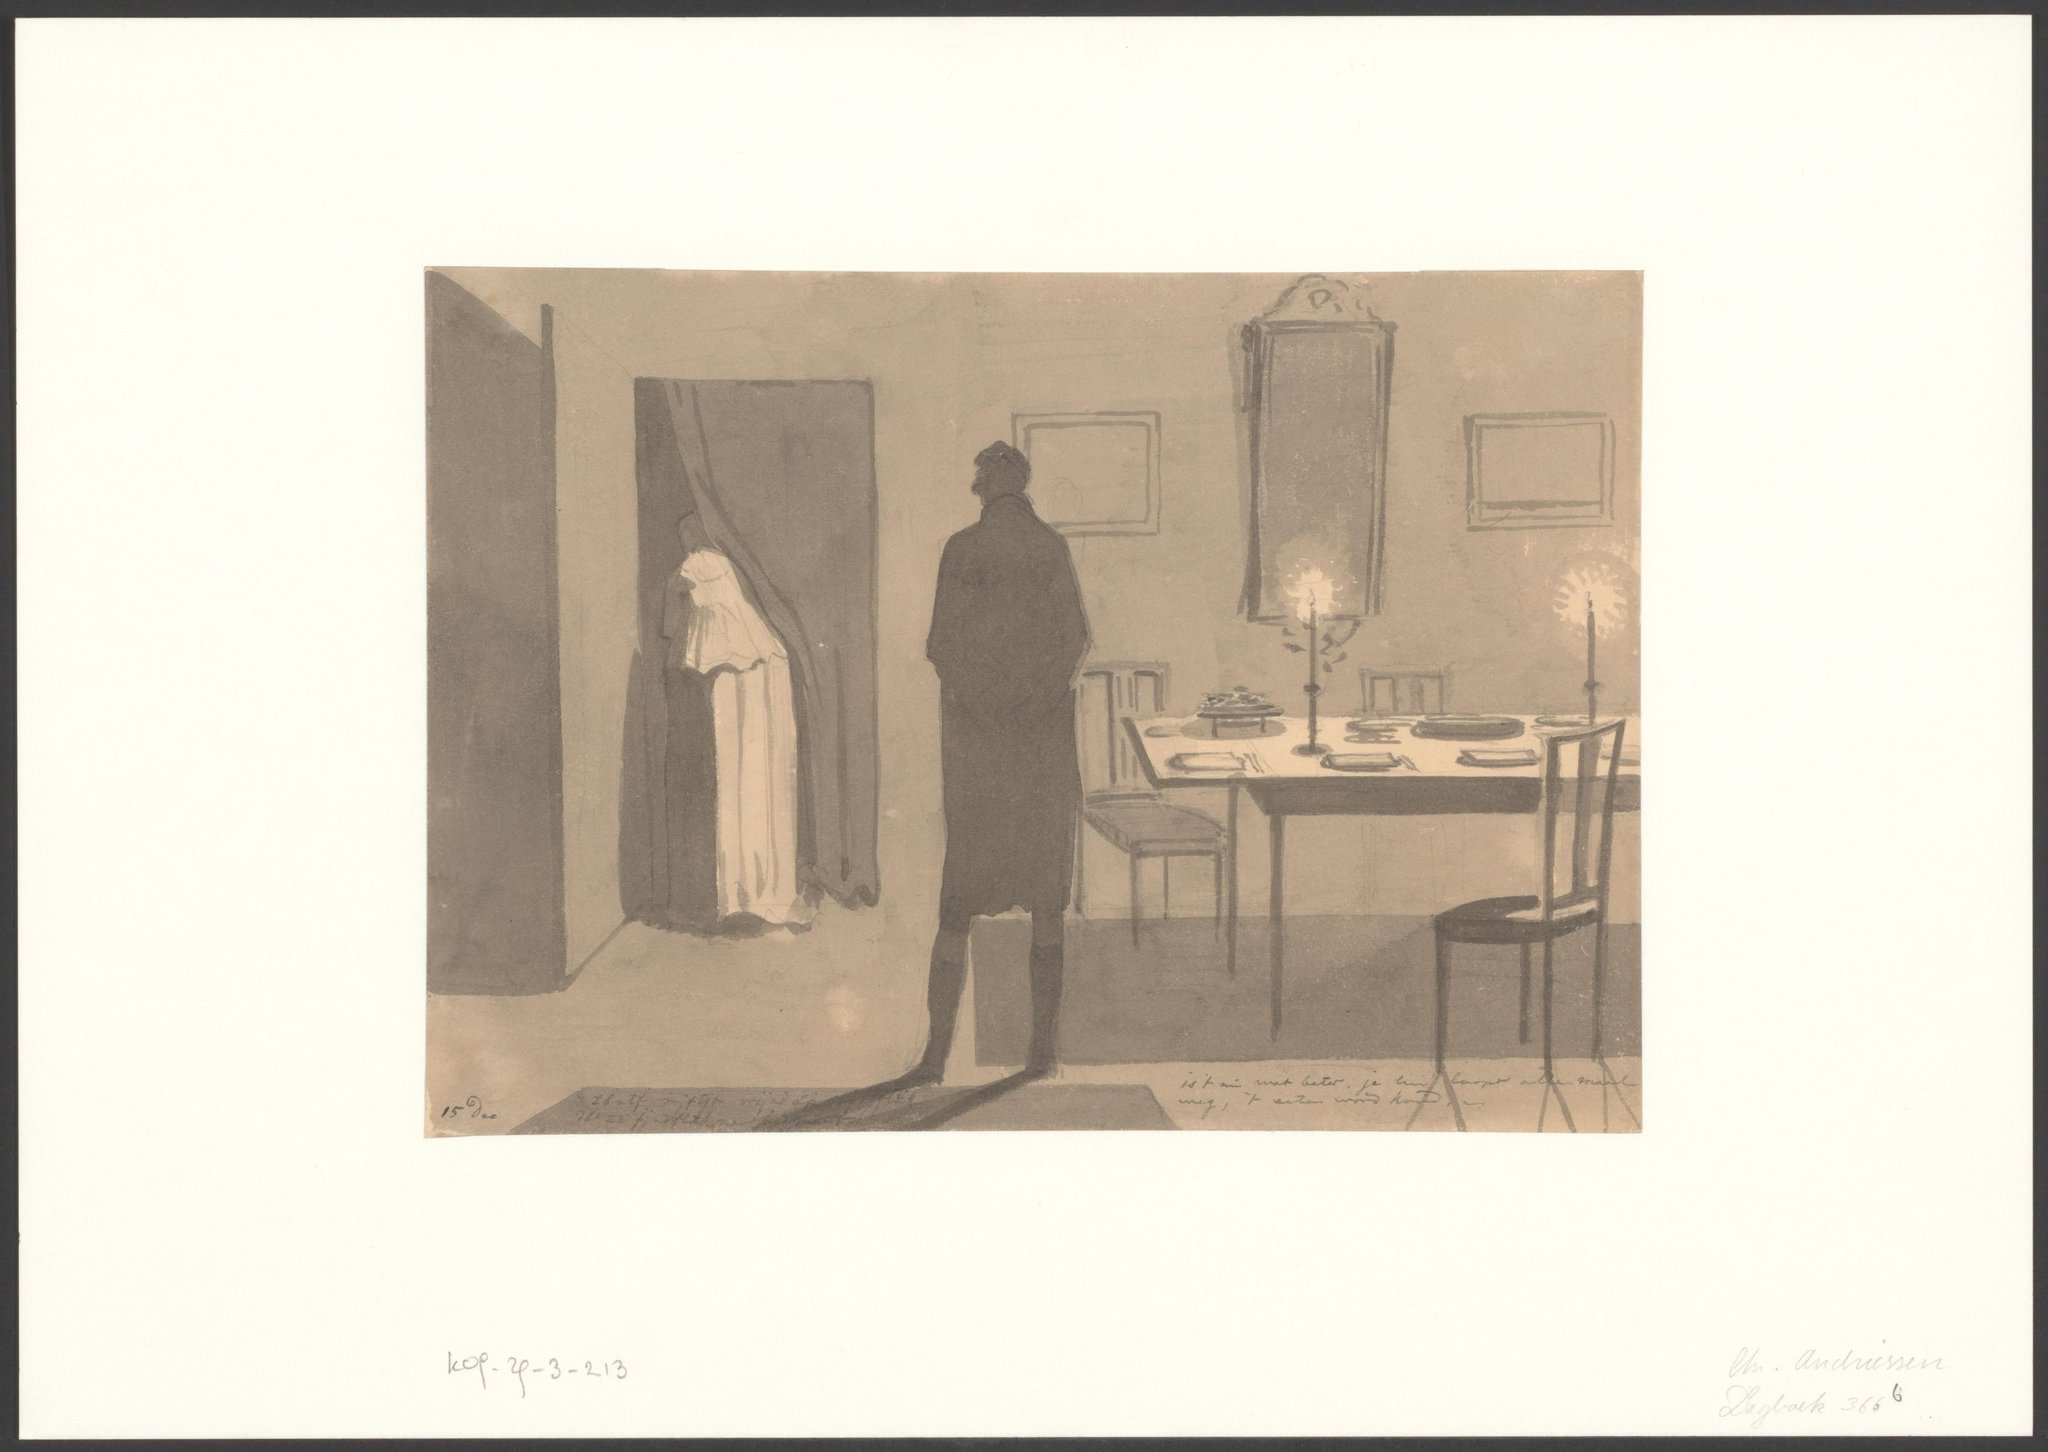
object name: drawing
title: Christiaan Andriessen staat bij een gedekte tafel, waar niemand aanzit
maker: christiaan andriessen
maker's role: draughtsman, print maker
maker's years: 1775-1846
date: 1805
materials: ink, paper, pencil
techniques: brush, pen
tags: amsterdam, print maker, draughtsman, christiaan andriessen, laid table: table-ware, table-decoration, etc., (family) meal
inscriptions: inscription, signature: ‘J Andriessen’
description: Het eten staat op tafel, maar iedereen is bezig met het naar bed brengen van tante Mietje Noordziek, die misselijk is geworden.